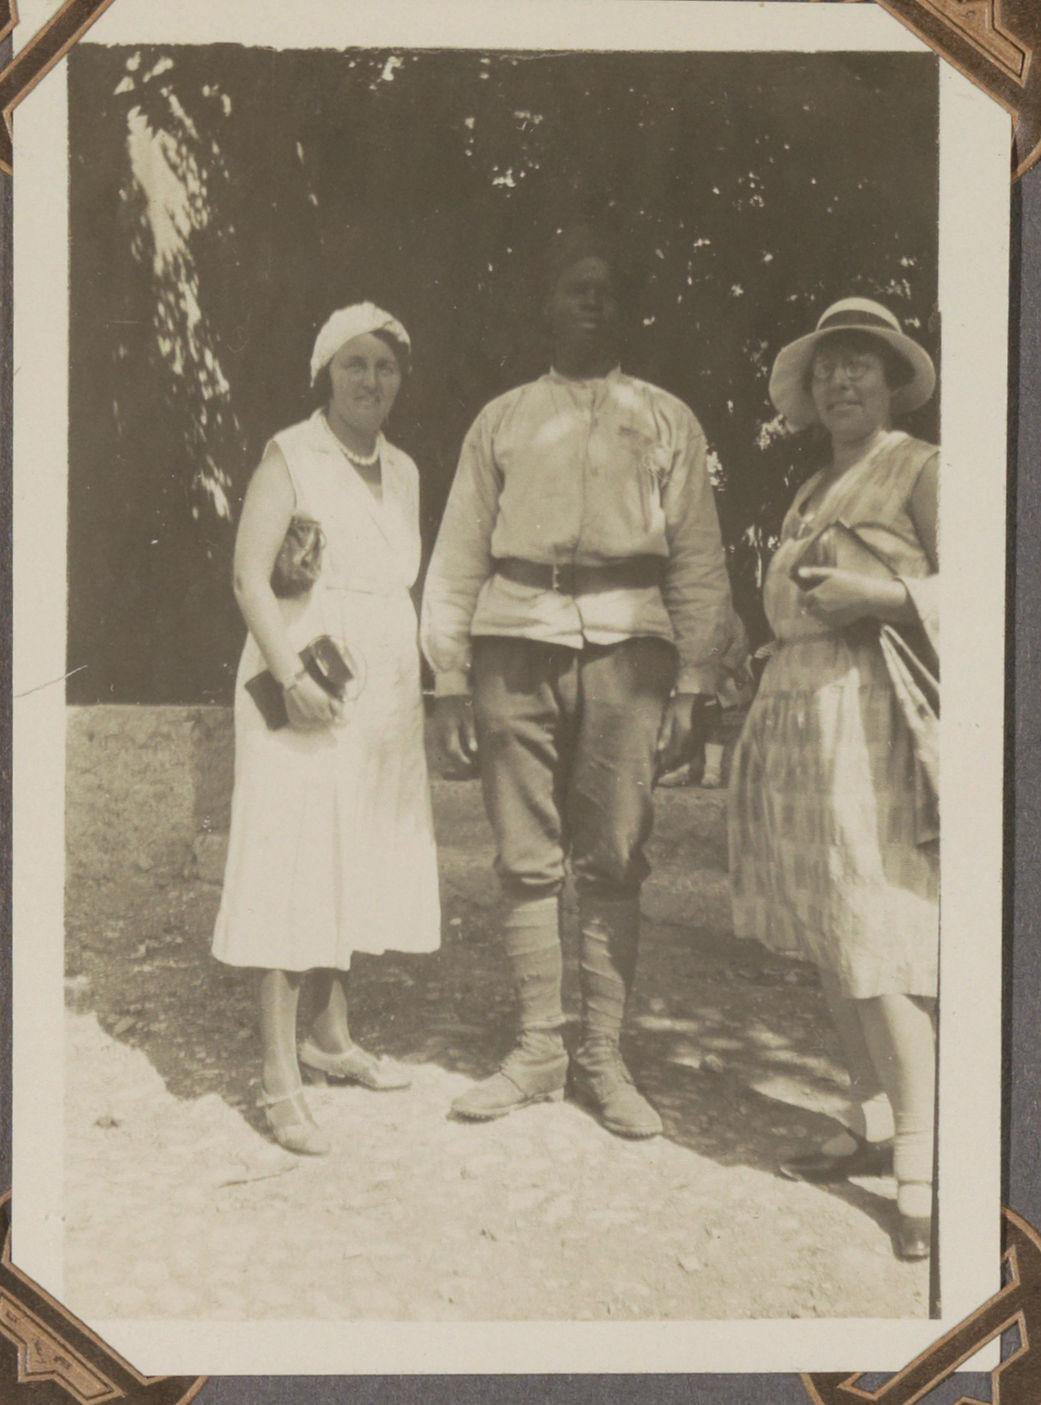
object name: photograph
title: Twee vrouwen en een Singalese militair, vermoedelijk in Zuid-Frankrijk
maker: Anonymous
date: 1930-1935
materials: photographic support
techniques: gelatin silver print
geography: southern france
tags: adult woman, land forces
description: Onderdeel van Fotoalbum met opnames van vakanties in Zuid-Frankrijk.